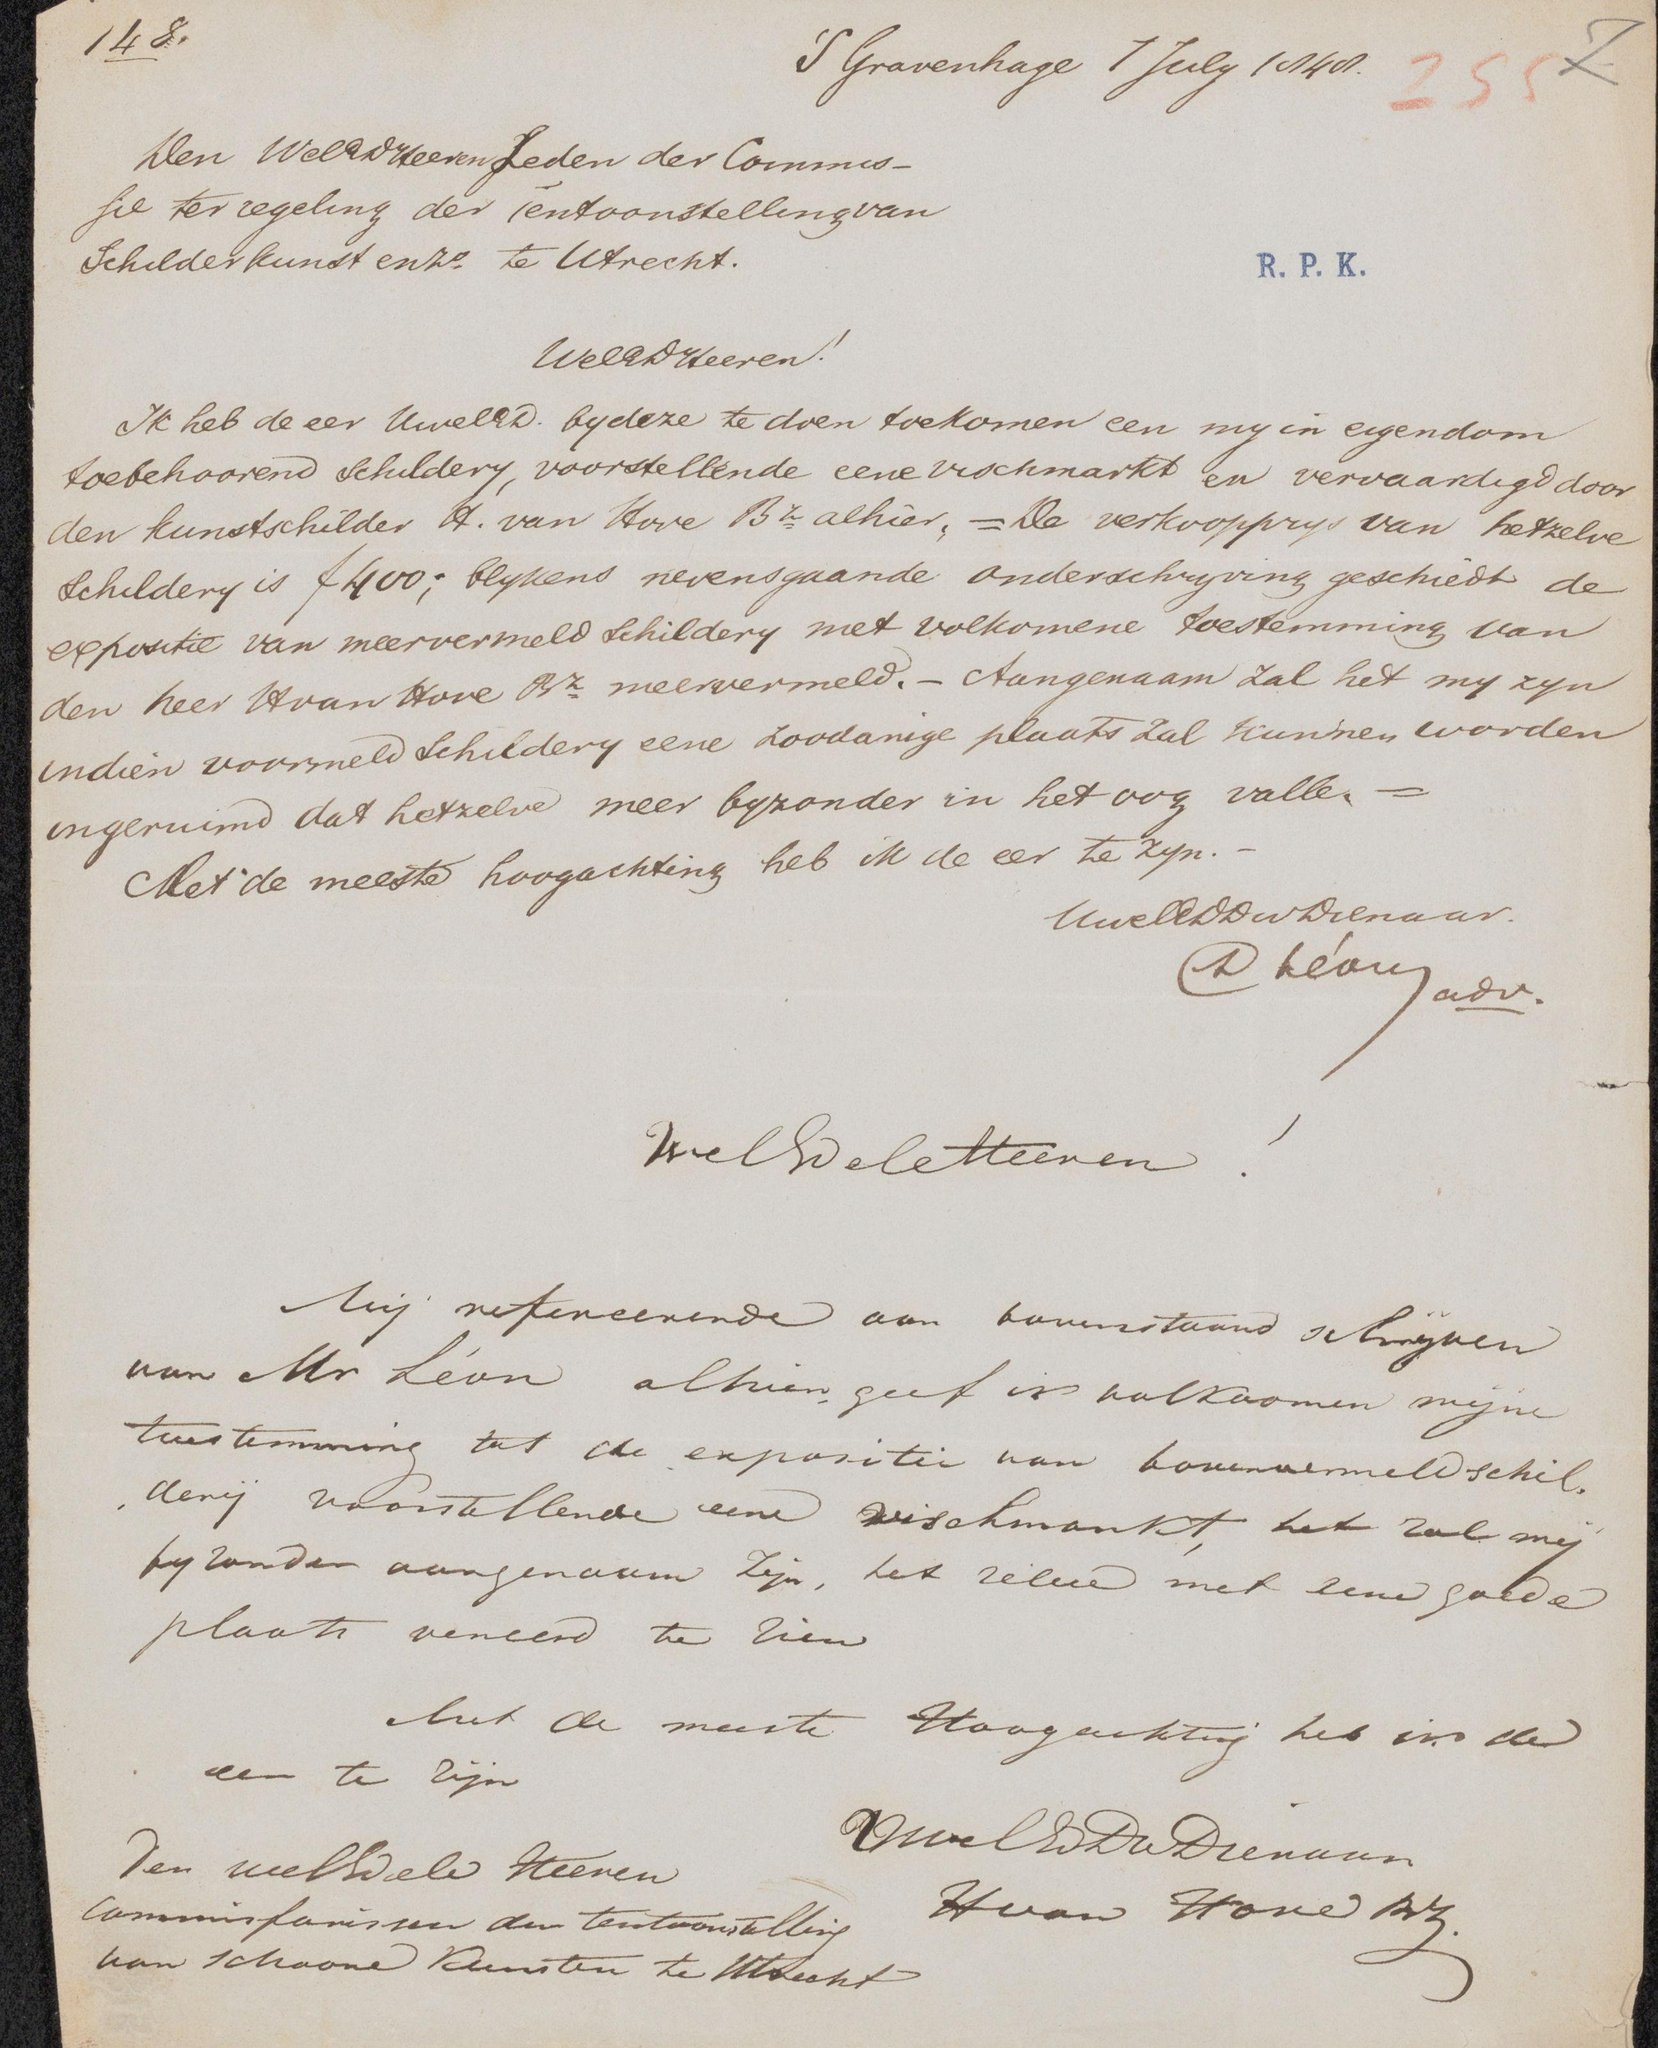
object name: letter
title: Brief aan de commissie van de Tentoonstelling van Levende Meesters in Utrecht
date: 1848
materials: ink, paper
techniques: pen, writing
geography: the hague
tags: art trade, art shop, painting (including book-illumination, miniature-painting), exhibition ~ art, money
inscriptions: seal, collector's mark: Lugt 2233